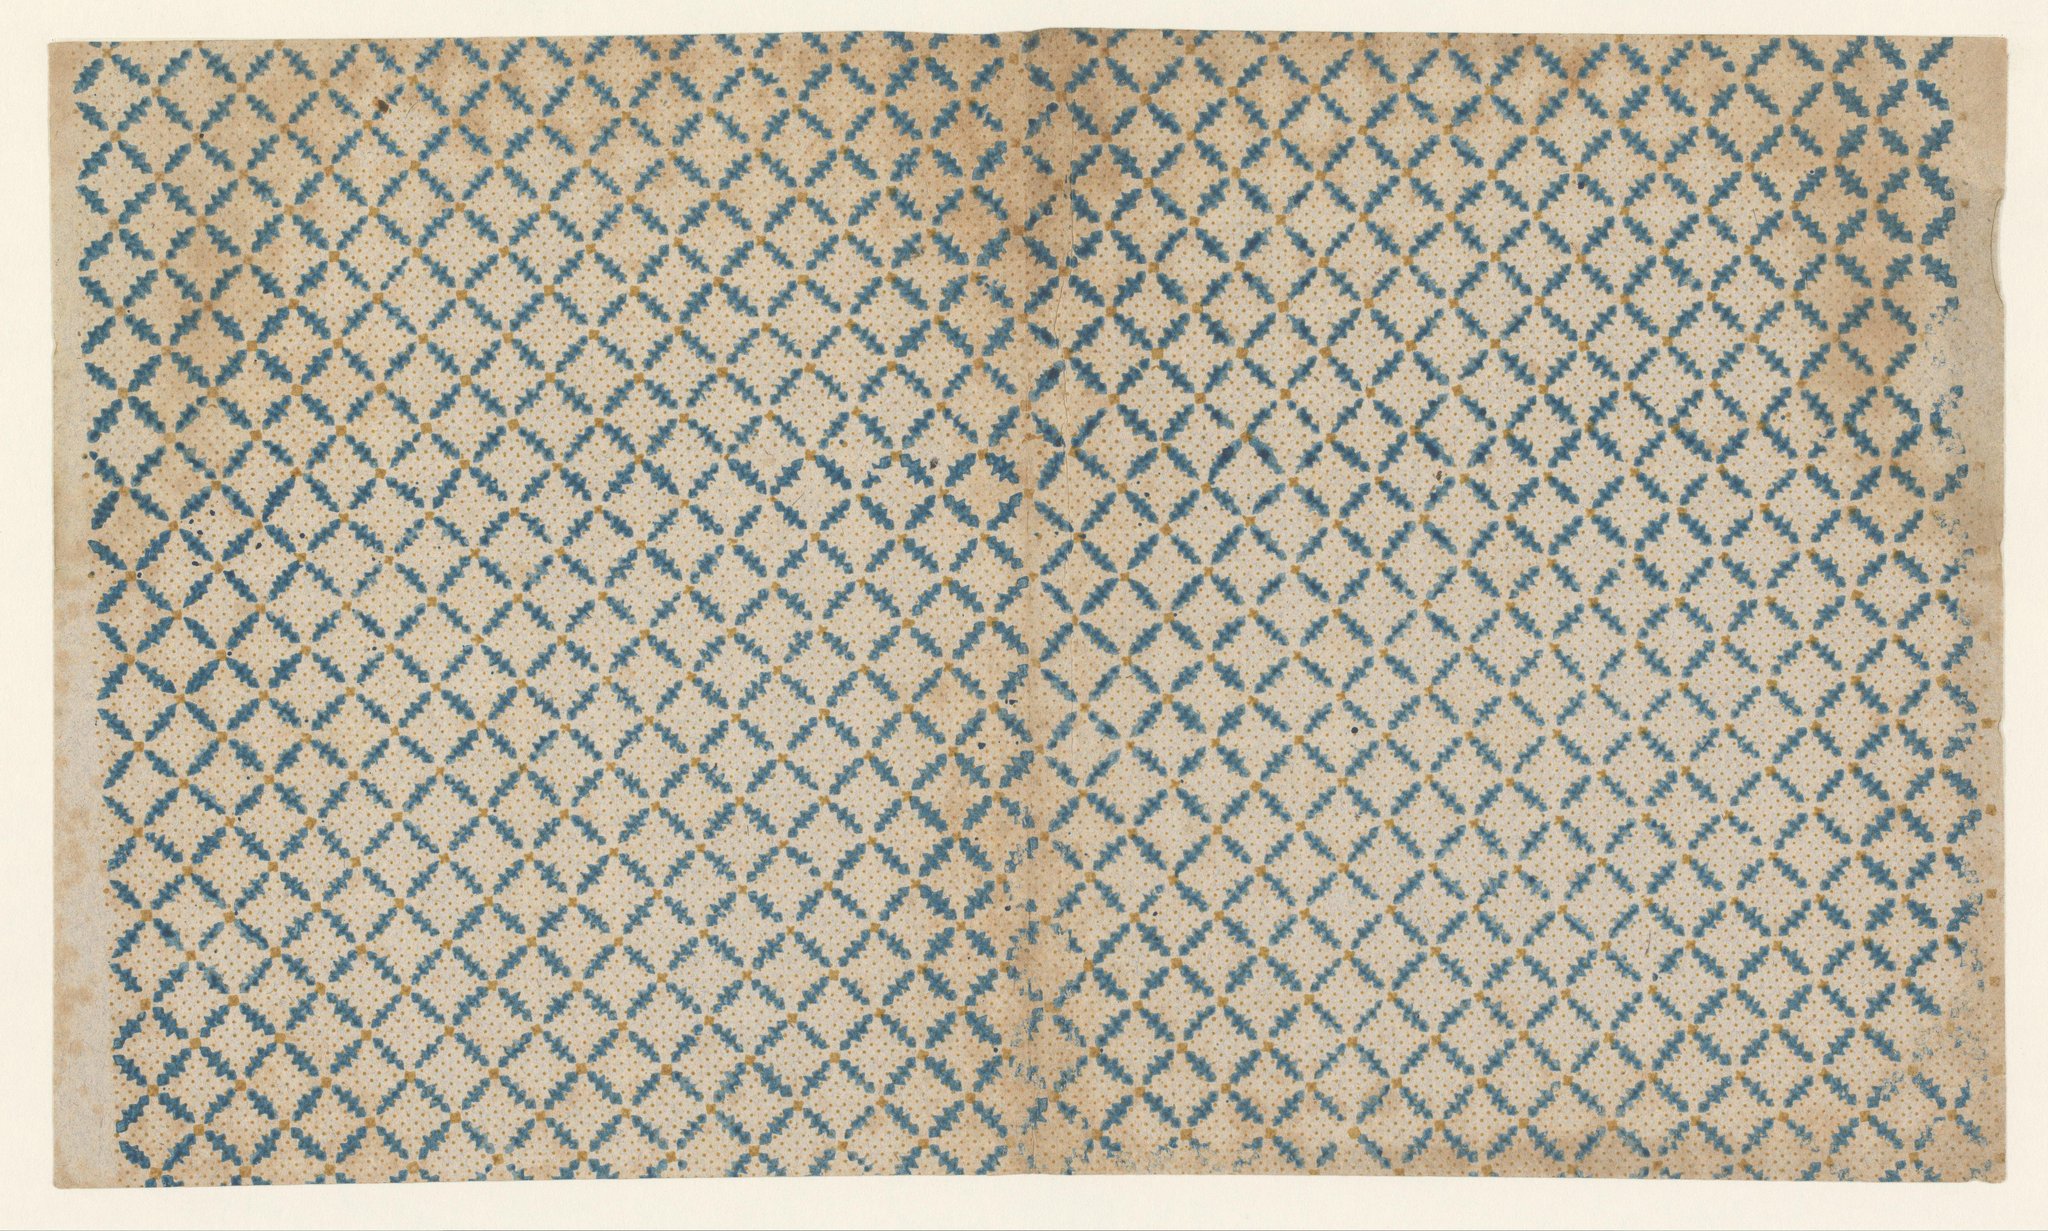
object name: wrapper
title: Blad met ruitenpatroon van gekartelde lijnen met doorlopend puntenfond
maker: Anonymous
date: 1750-1900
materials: paper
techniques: printing block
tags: ornament ~ geometric motifs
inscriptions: collector's mark: Lugt 2760, collector's mark: Lugt 2228